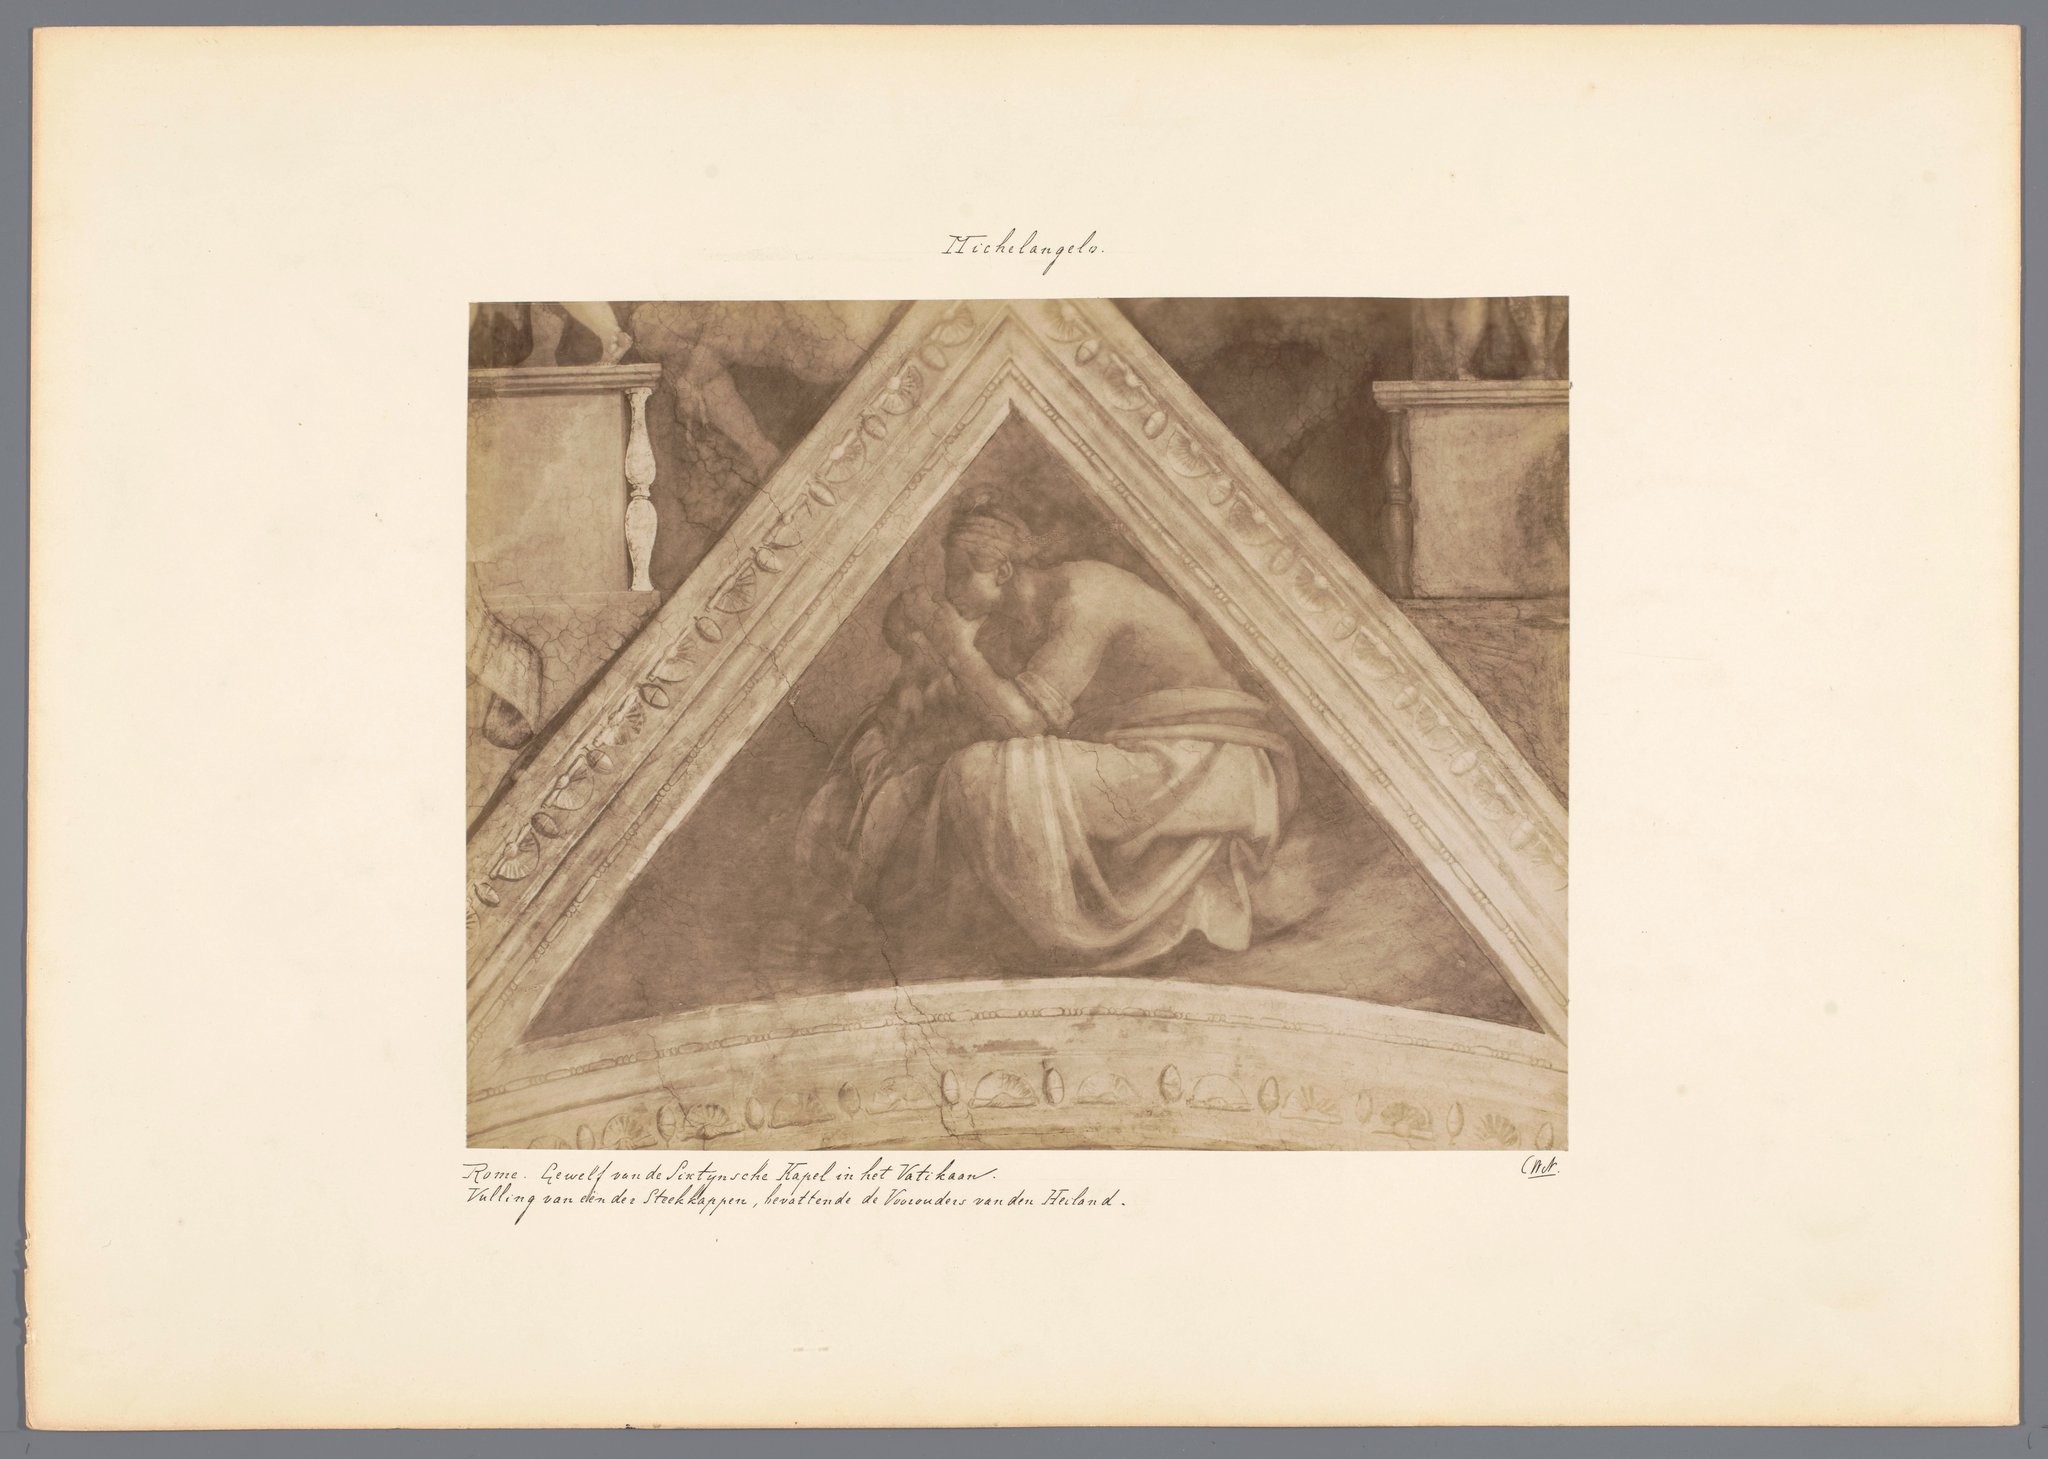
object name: photograph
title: Fotoreproductie van een detail van het fresco door Michelangelo in de Sixtijnse Kapel in Rome, voorstellend een voorouder van het Heiland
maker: Anonymous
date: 1875-1900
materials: cardboard, photographic support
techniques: albumen print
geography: vatican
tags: painting (including book-illumination, miniature-painting) (+ plaster ~ arts), ancestors and parents of christ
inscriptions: collector's mark: ‘INSTITUUT VOOR KUNST-NIJVERHEIDSONDERWIJS GABRIËL METSUSTRAAT No. 16 AMSTERDAM’, inscription: ‘CWN.’, collector's mark: ‘KUNSTNIJVERHEIDSCHOOL QUELLINUS AMSTERDAM FRANS HALSSTRAAT 14.’